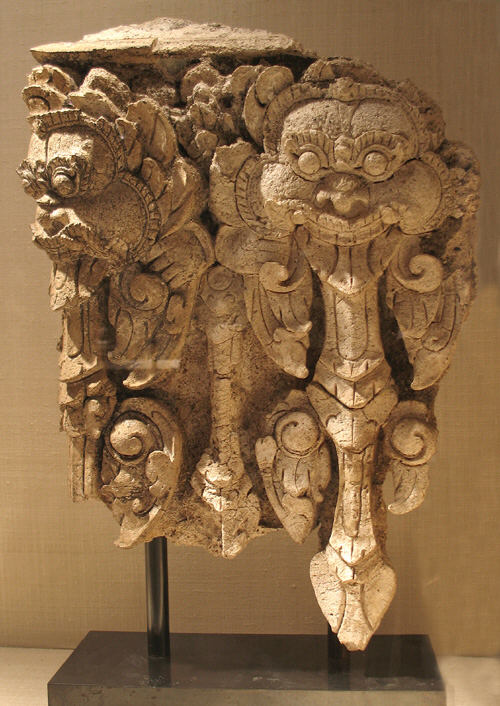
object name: architectural panel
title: Architectural Panel with Two Kala Heads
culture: thai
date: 1001-1100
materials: plaster